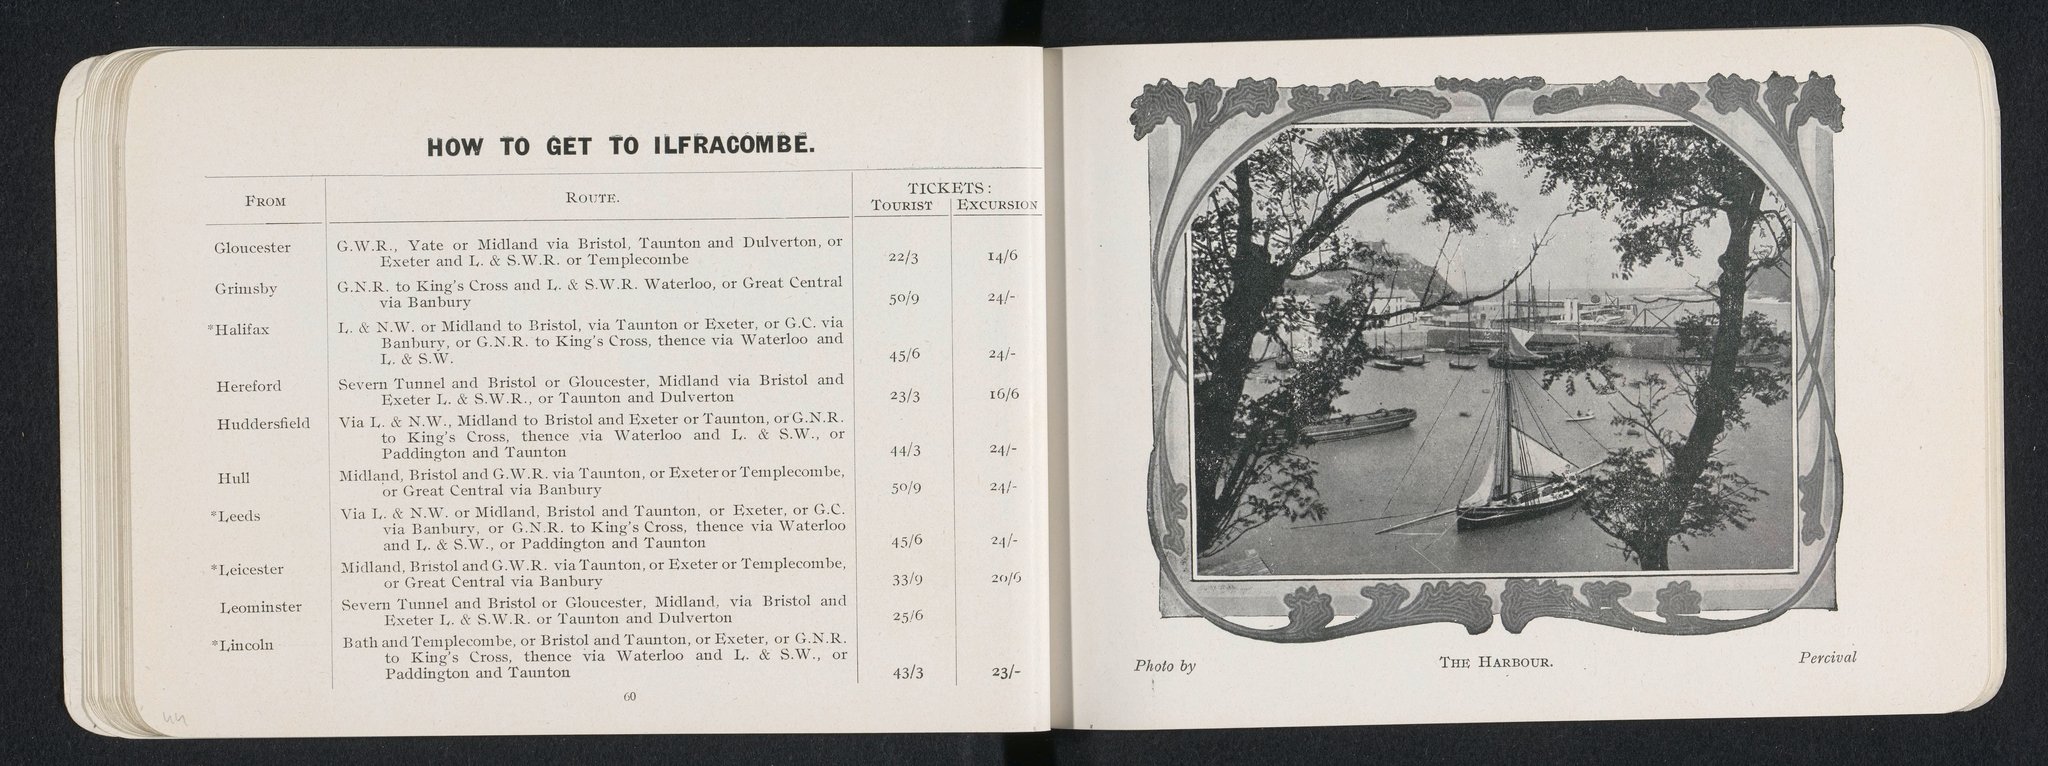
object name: page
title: The harbour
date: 1900-1920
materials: paper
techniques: autotype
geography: ilfracombe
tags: harbour